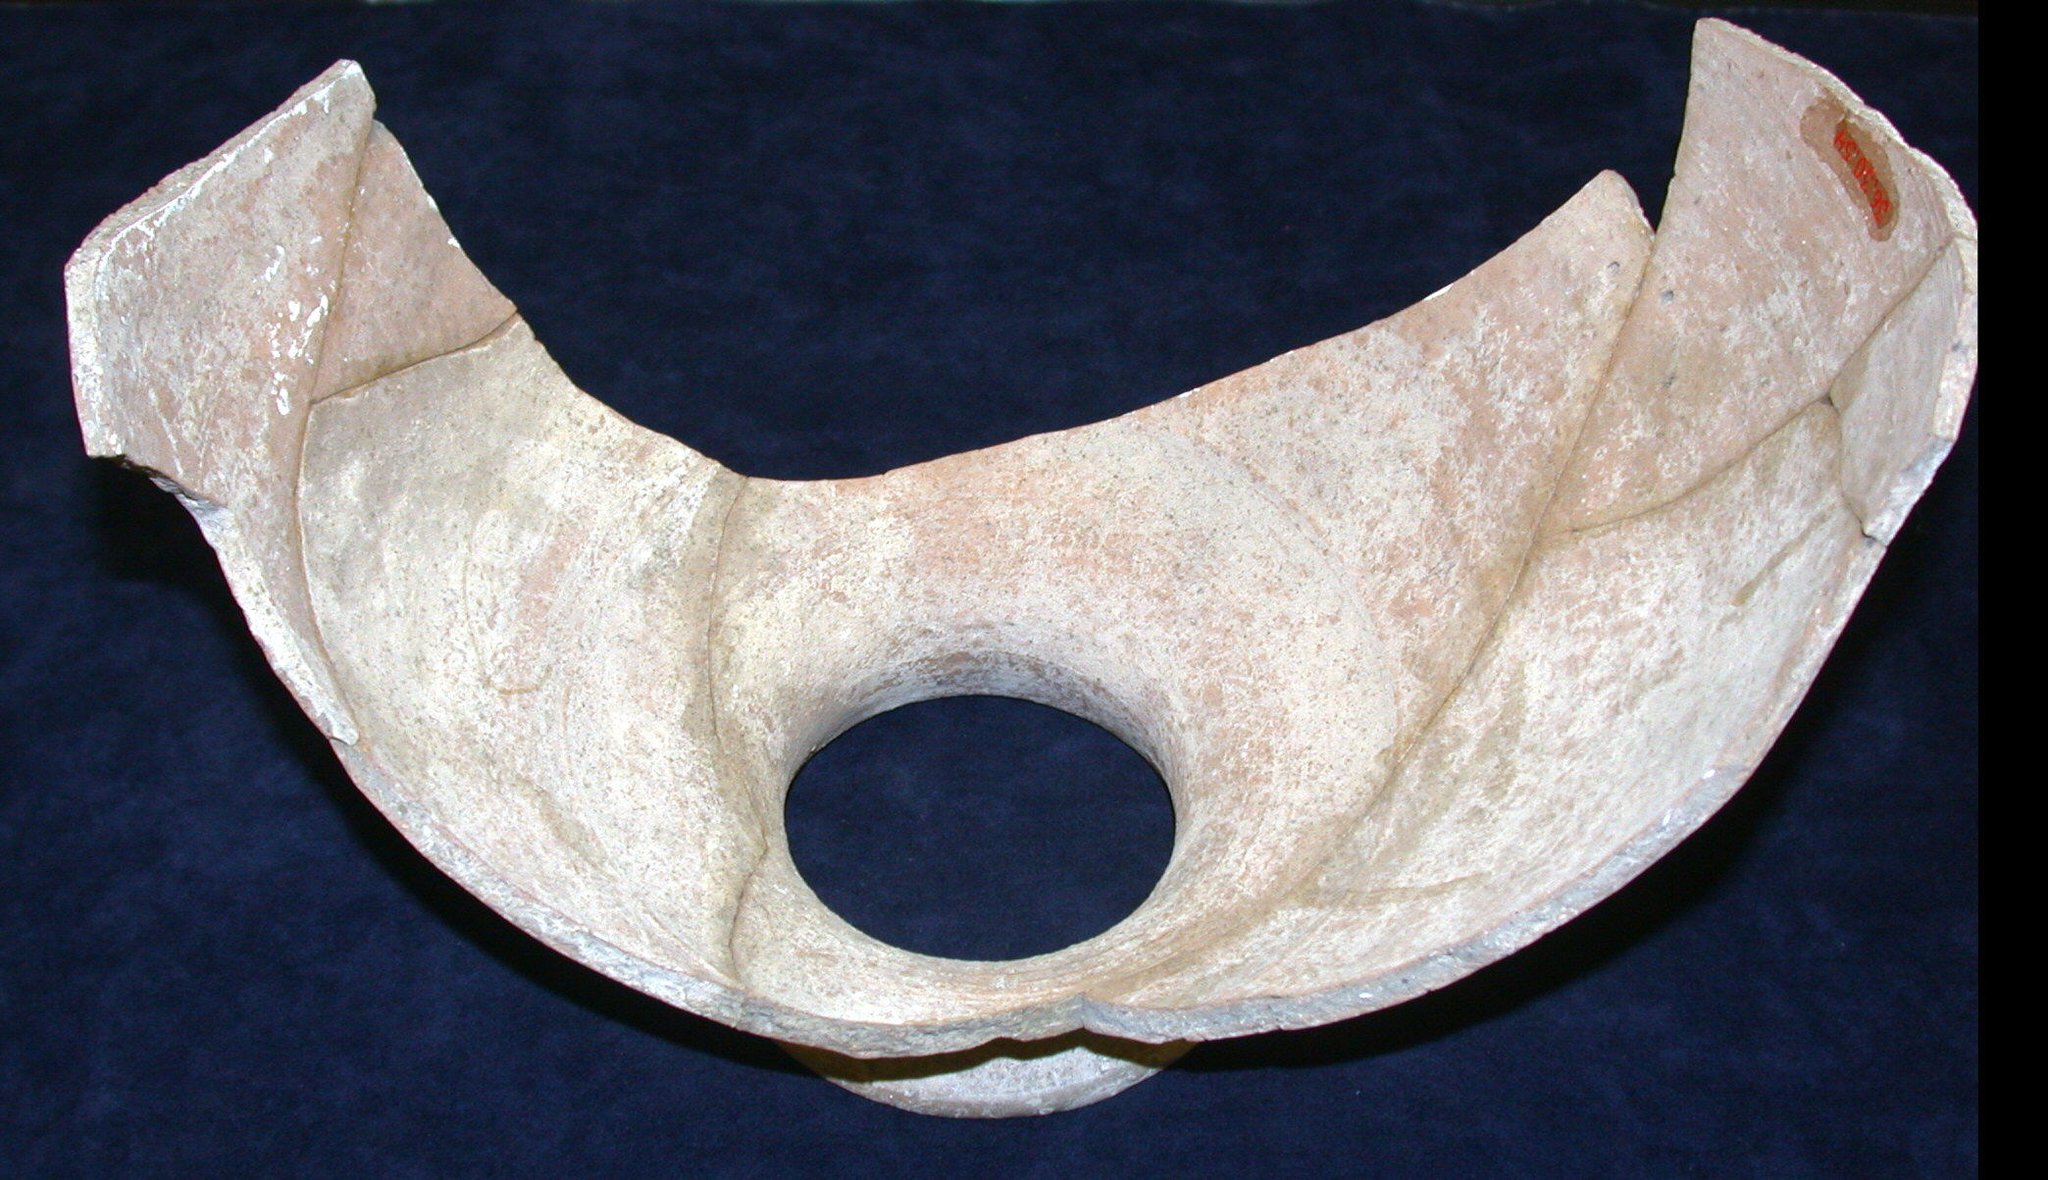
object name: jar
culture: parthian or sasanian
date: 1-700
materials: ceramic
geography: iran